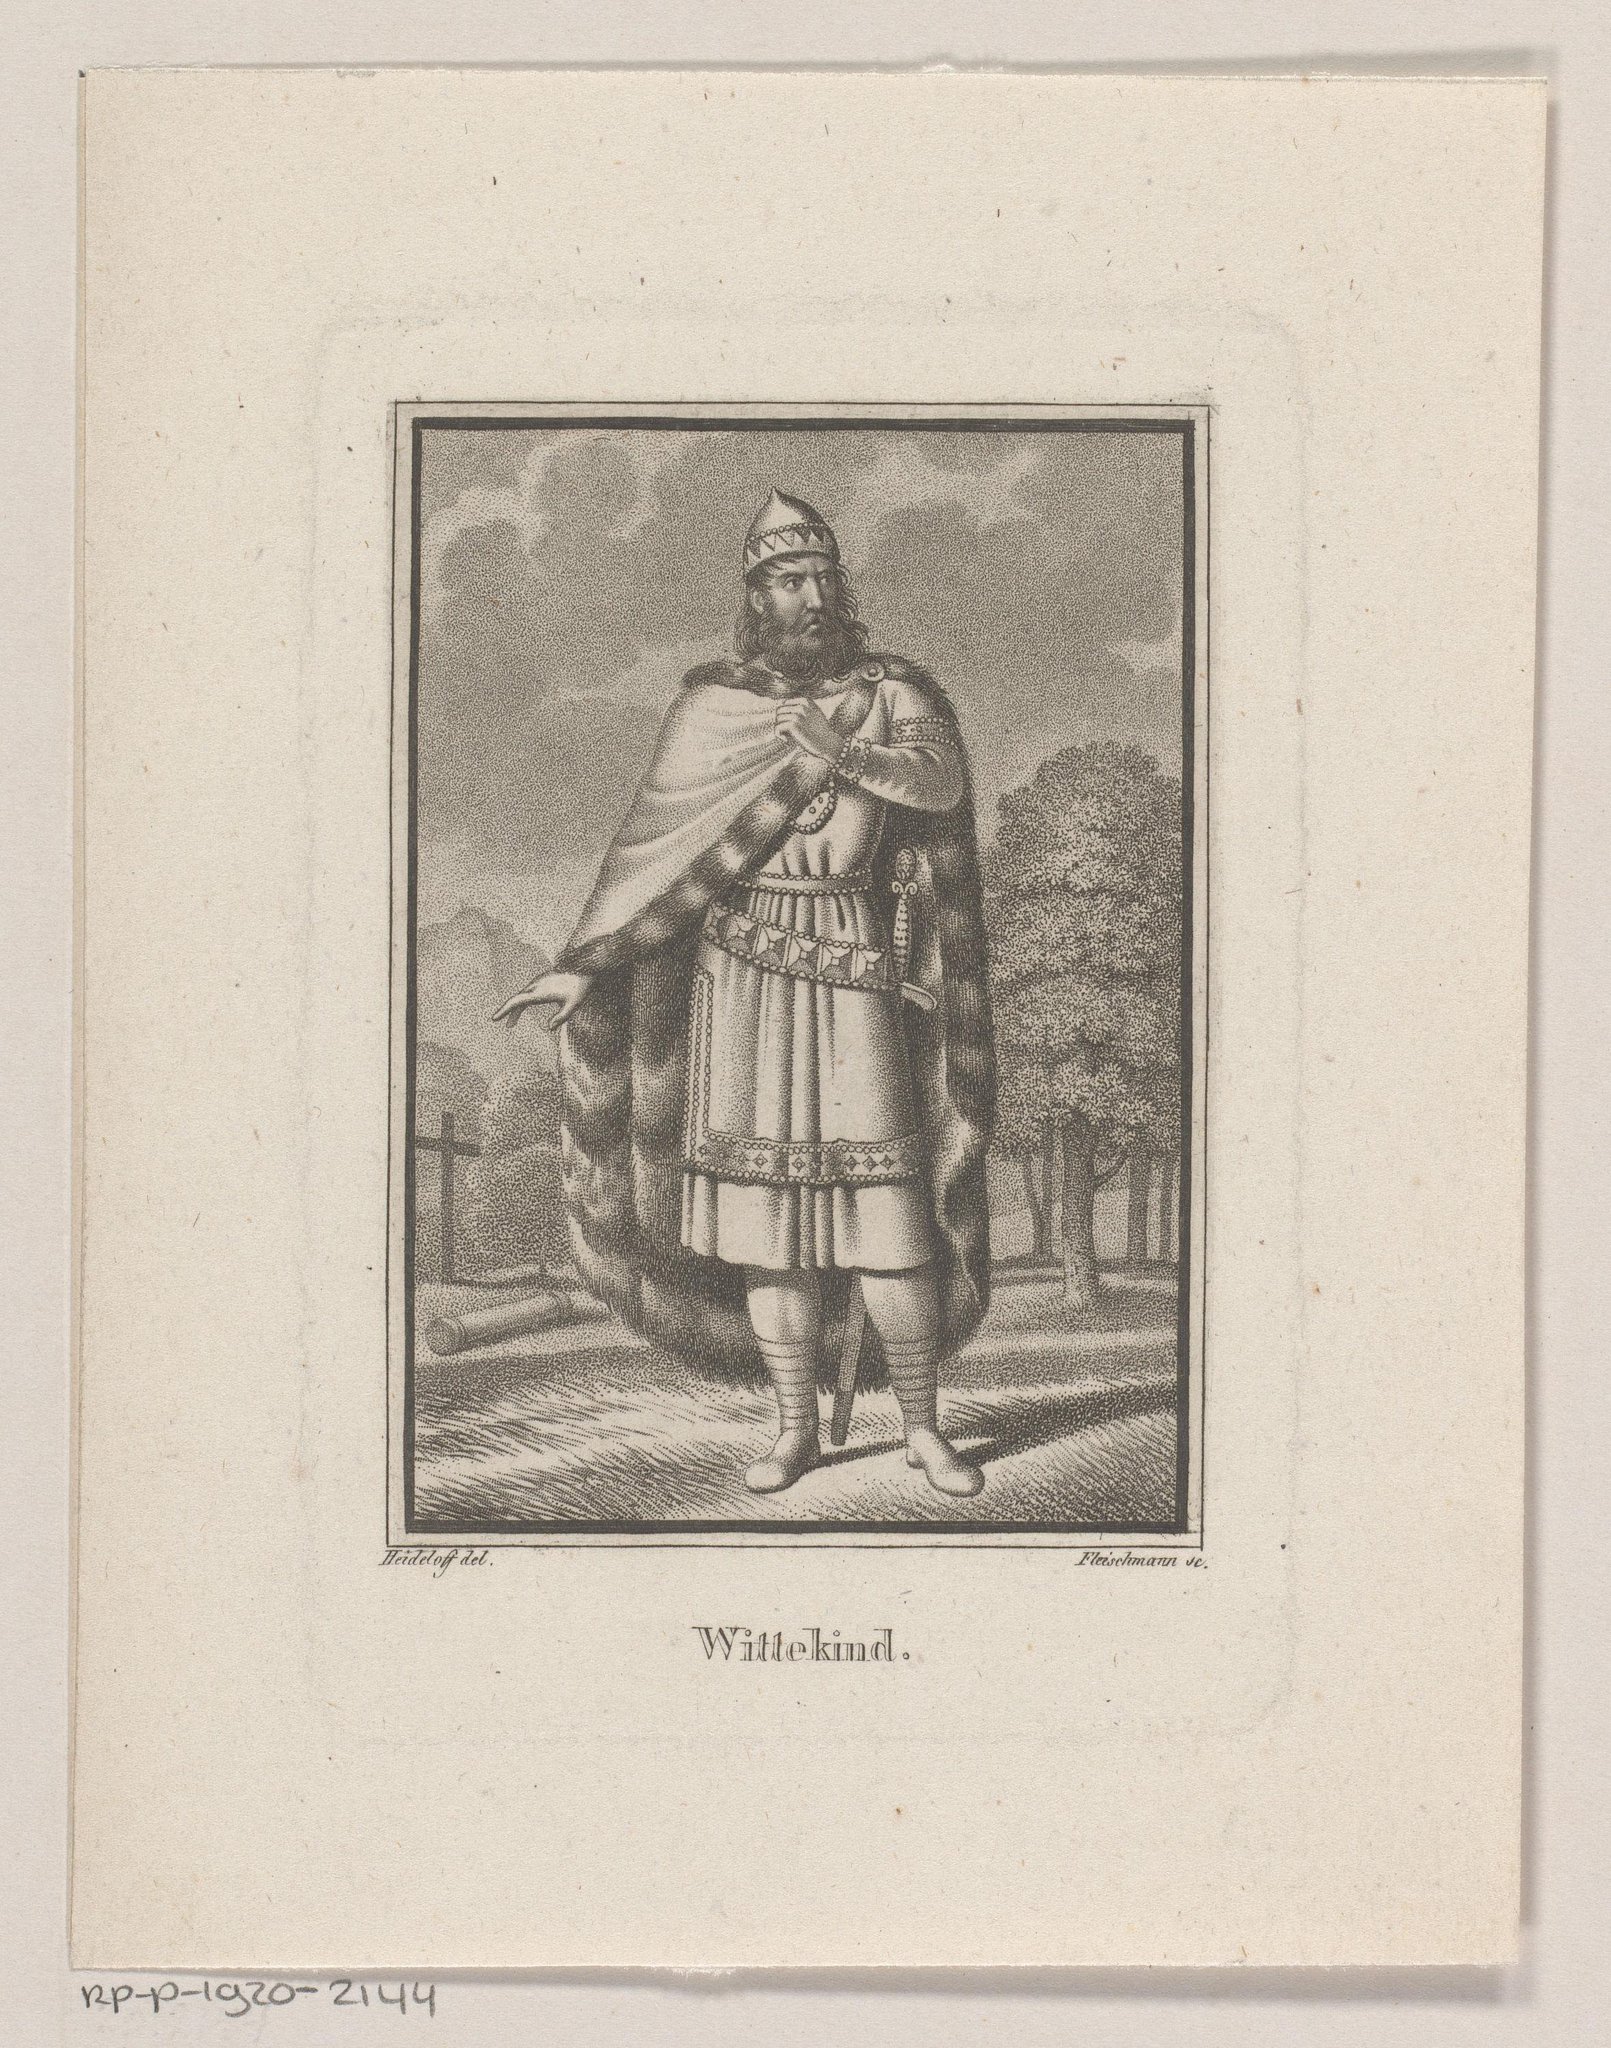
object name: book illustration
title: Wittekind.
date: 1821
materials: paper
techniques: roulette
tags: crown (symbol of sovereignty), historical persons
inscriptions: collector's mark: Lugt 2228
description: Prent waarschijnlijk uit: Jerrer, Georg Ludwig. Geschichte der Teutschen für die Jugend (...). Neurenberg: Friedrich Campe, 1821.